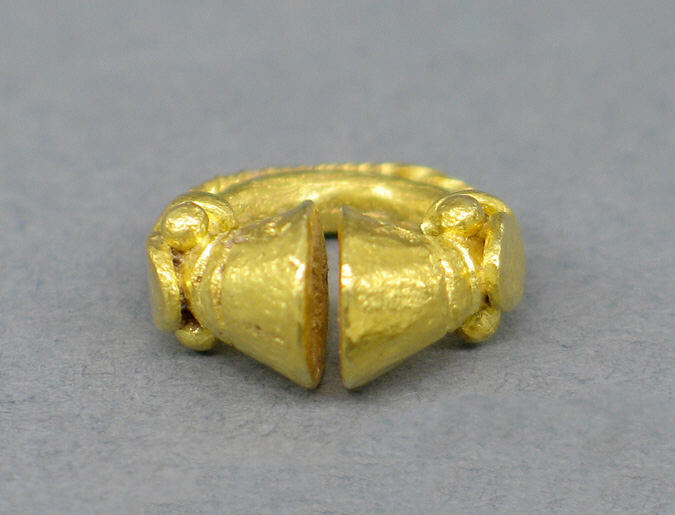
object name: ear ornament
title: Circular Ear Ornament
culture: indonesian, javanese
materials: gold